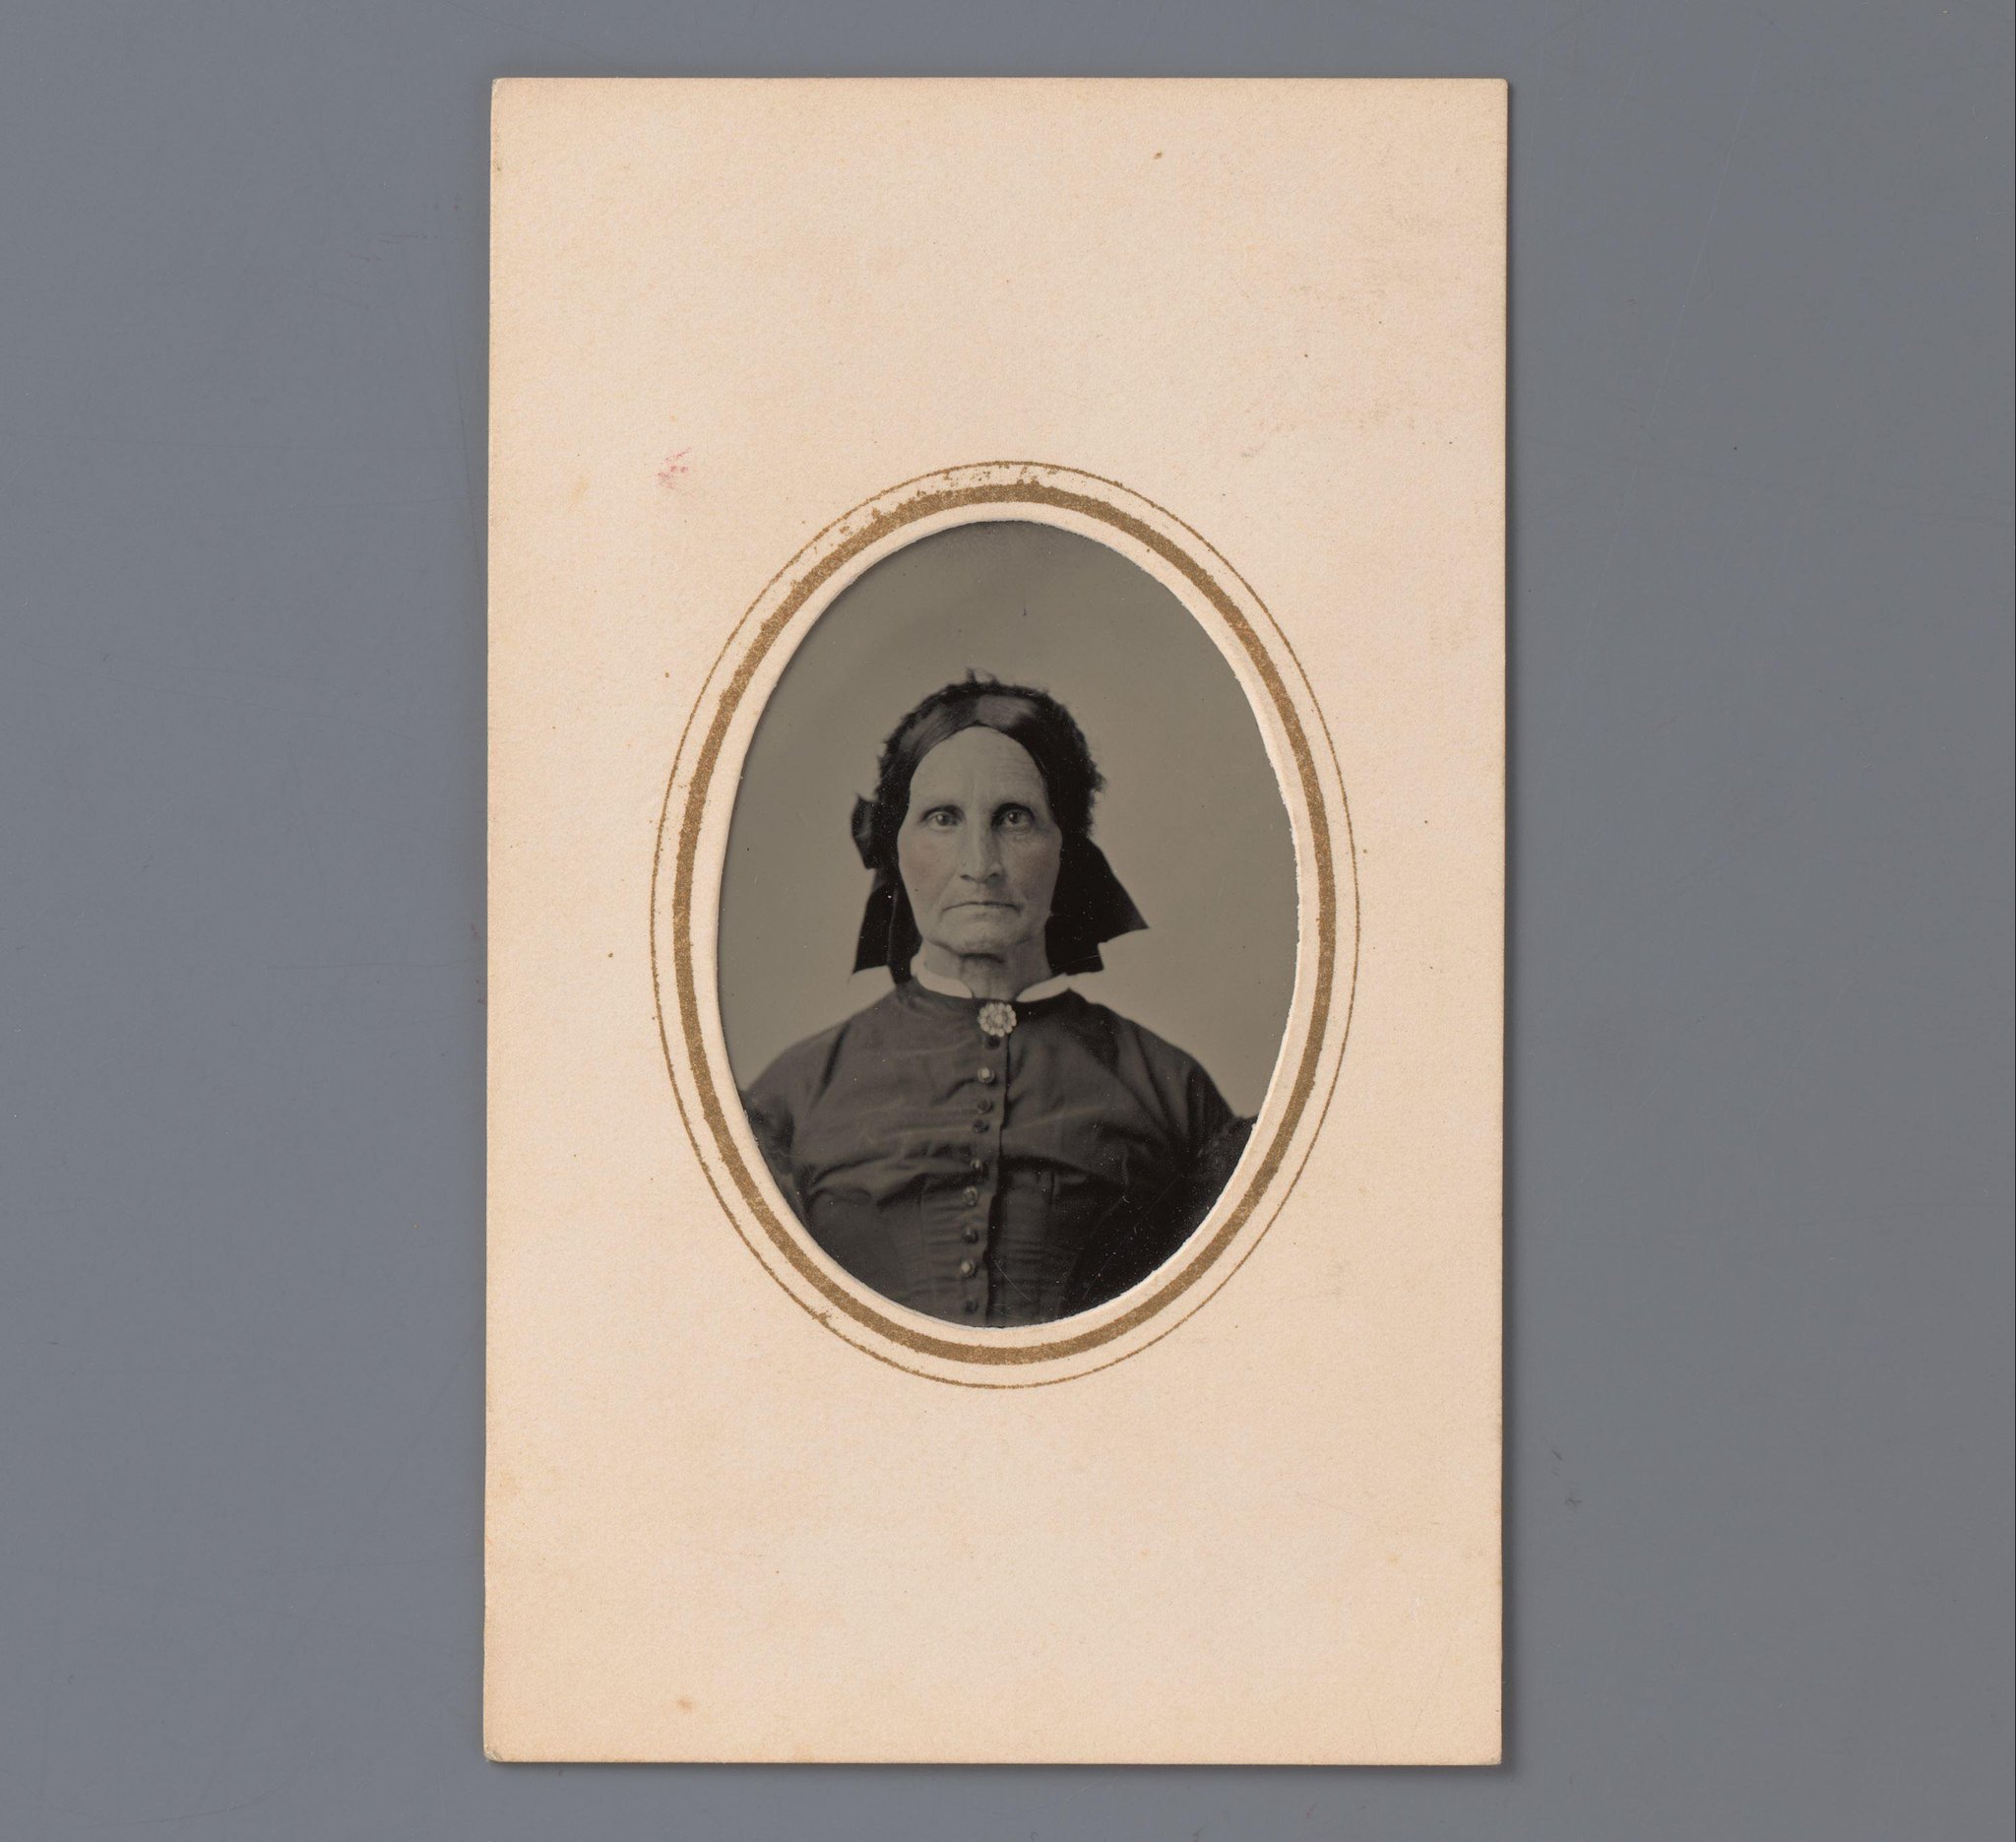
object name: photograph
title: Portret van een onbekende vrouw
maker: g.p. laselle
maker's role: fotograaf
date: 1855-1900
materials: cardboard, iron, paper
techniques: ferrotyping, hand coloring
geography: boston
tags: historical persons - bb - woman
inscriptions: inscription: ‘Excelsior Ferrotypes made at/ No. 4/ SUMMER ST.,/ BOSTON./ G. P. LASSELLE,’, inscription: ‘U.S. INTER.RE[L]/ PROPRIETARY/ TWO/ CENTS’